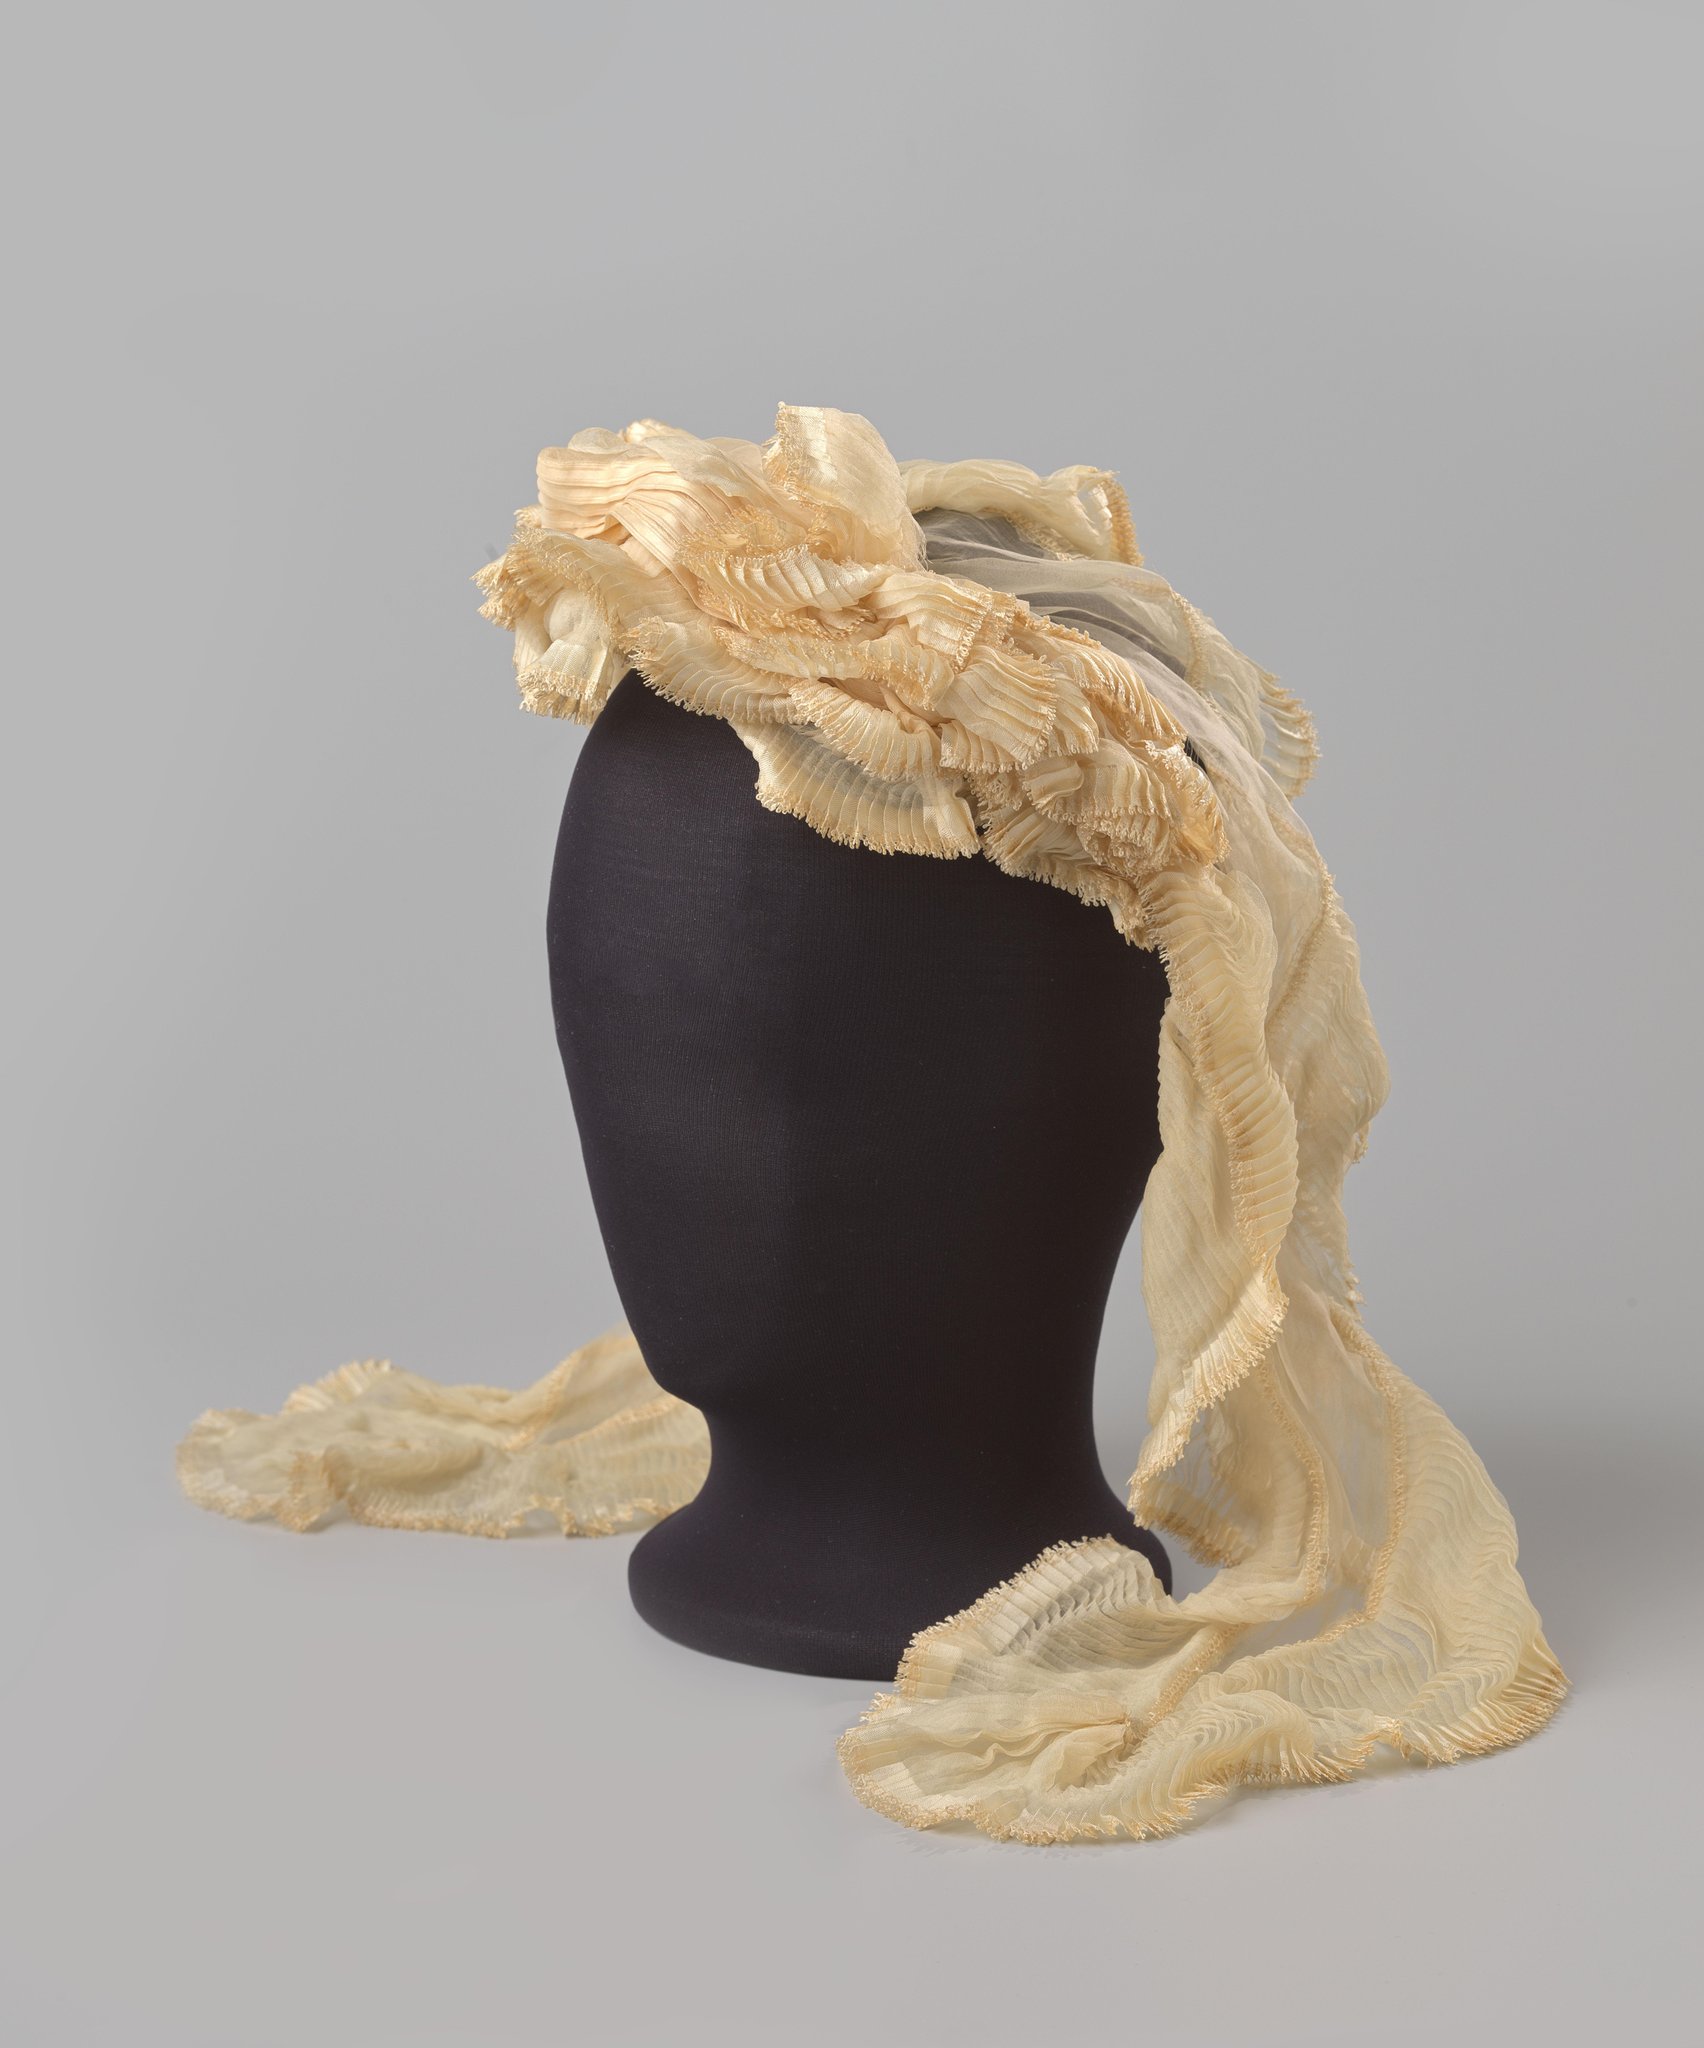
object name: womenswear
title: Hoed van zijden gaas en lint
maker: Anonymous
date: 1870-1880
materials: textile, metal, silk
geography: western europe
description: Hoedje van creme zijden gaas en smal lint. een gaze de lisse dat vlak gebruikt is en gepliseerd, waaraan aan de randen een satijnen zoom is geweven, zeer klein picotpassement. Voor op het hoofd te dragen hoefijzervormige beugel, geraamte van laiton. Gaze de lisse in poefen en in een staande rand versierd met vijf smalle satijnen lintjes. Gepliseerde stroken hangen van voren in dubbele rijen neer.